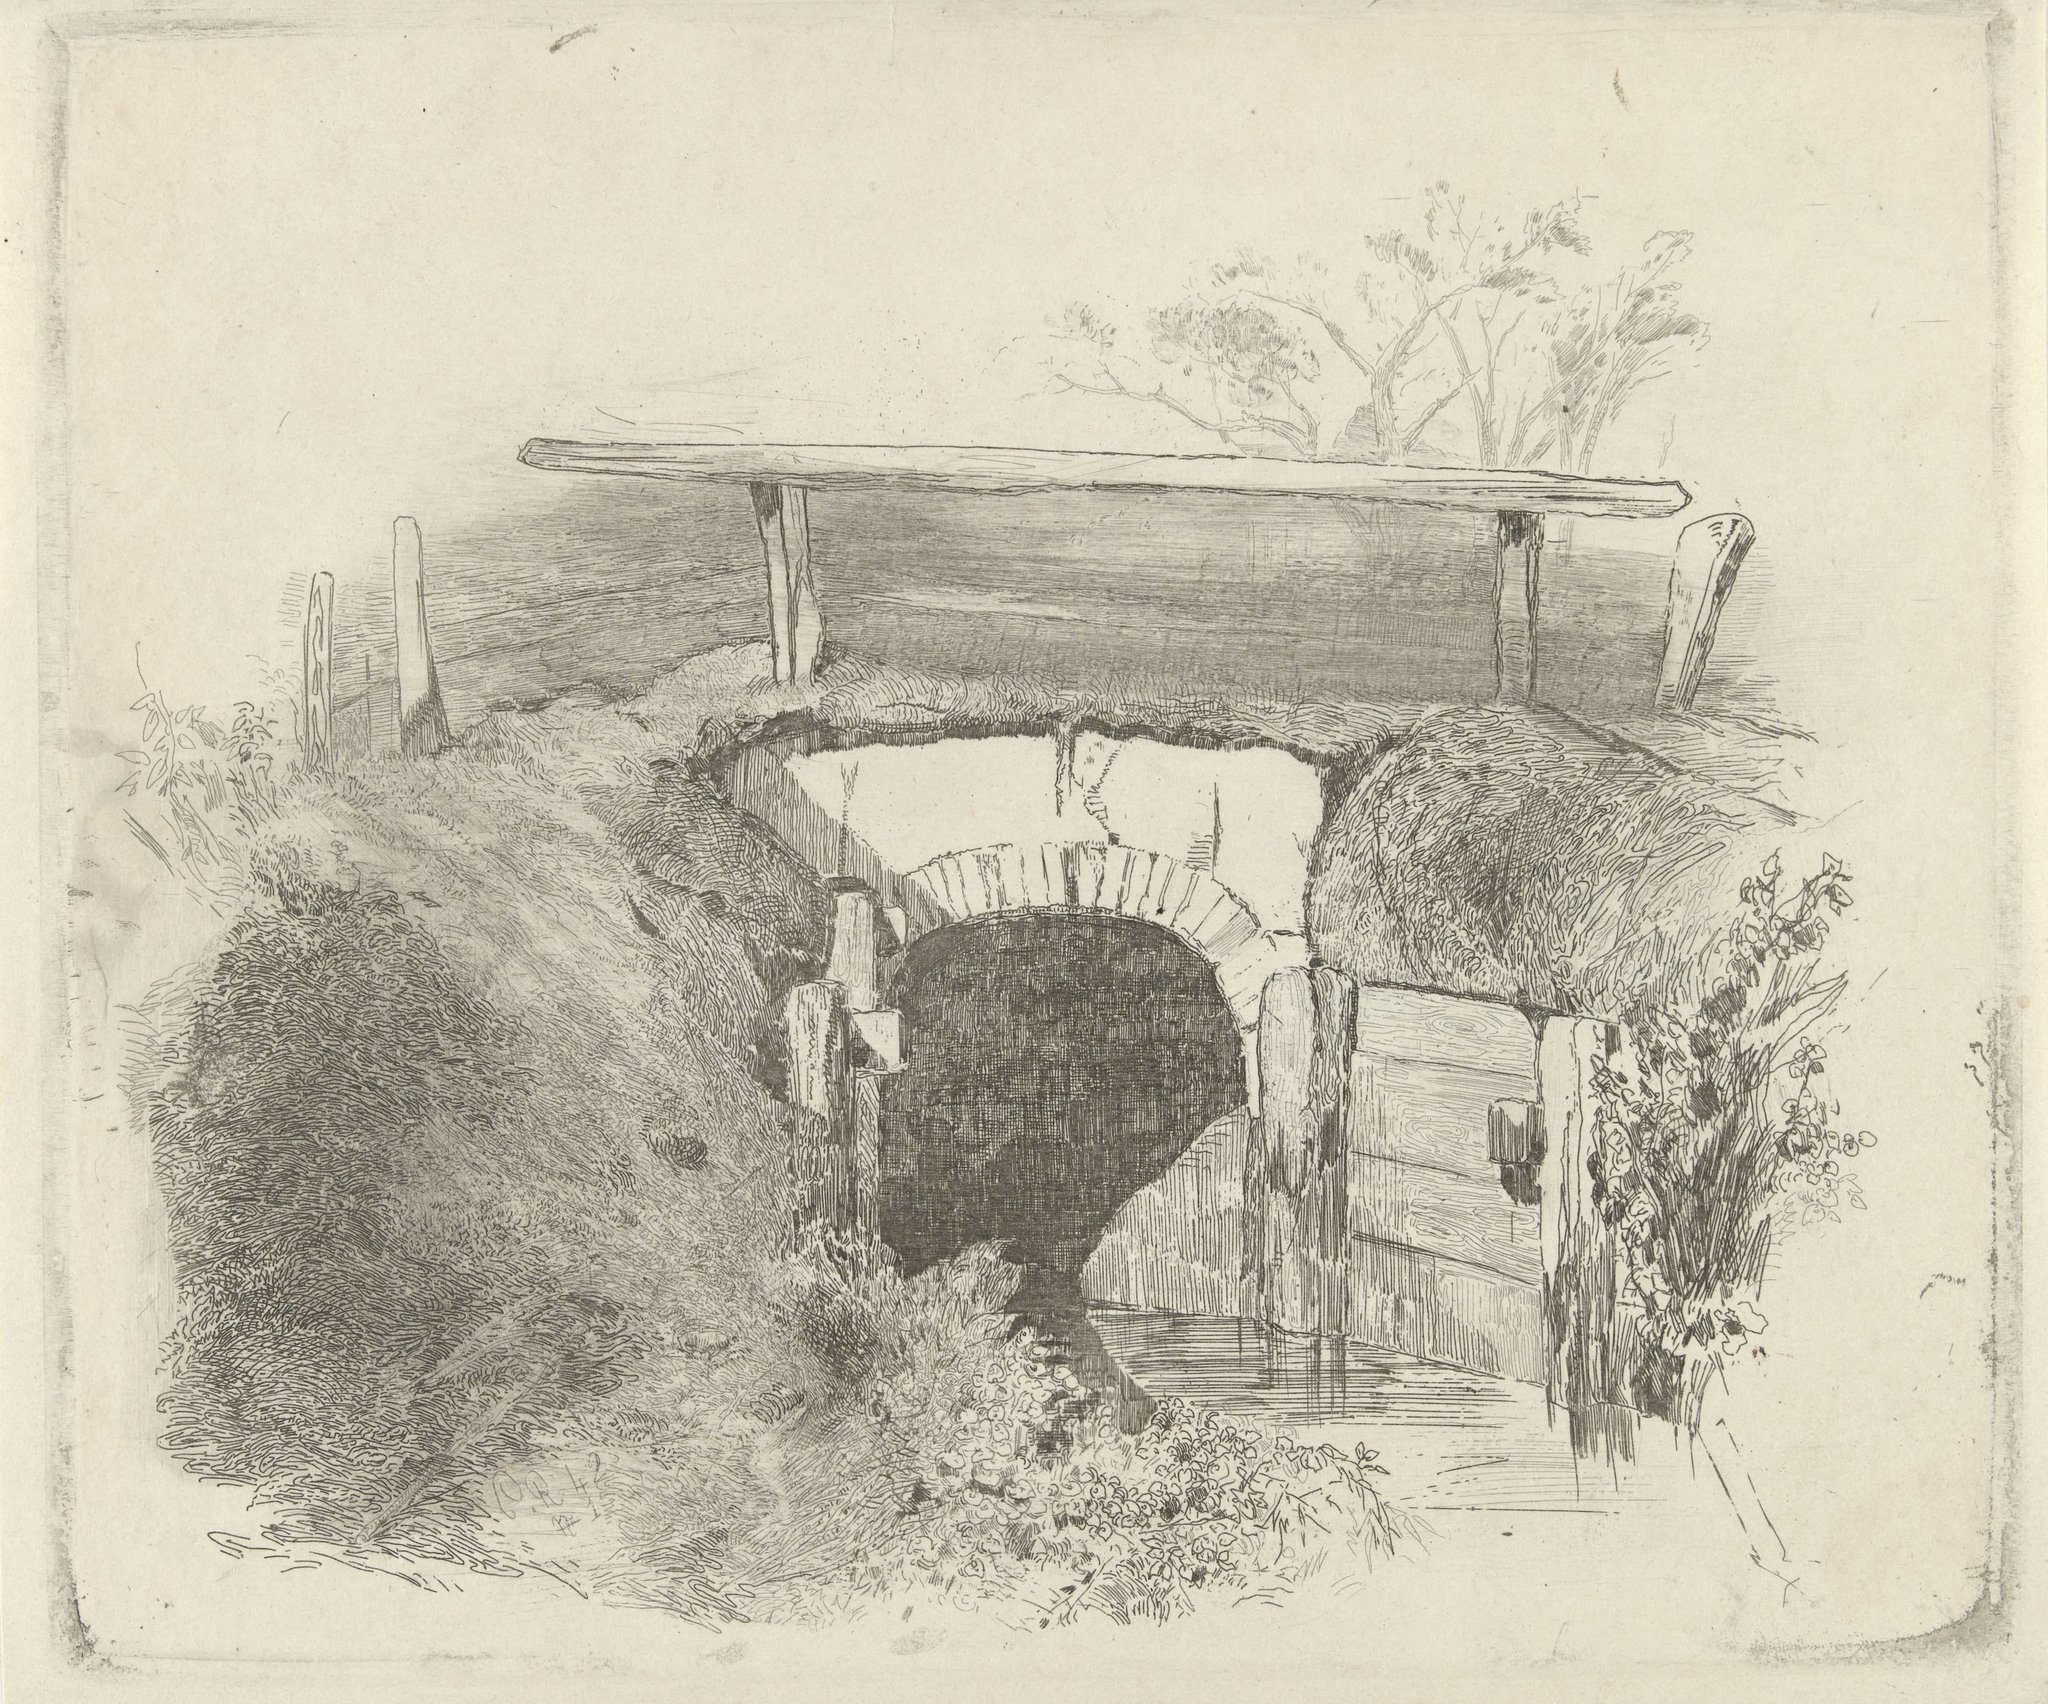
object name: print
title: Brug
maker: charles rochussen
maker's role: draughtsman, painter, print maker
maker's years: 1814-1894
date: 1842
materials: paper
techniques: drypoint, etching, intaglio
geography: the hague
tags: bridge, small canal, ditch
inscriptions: collector's mark: Lugt 2228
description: Gemetselde duikerbrug, met houten leuningen, over een sloot. Bij de sloot staan bloemen.